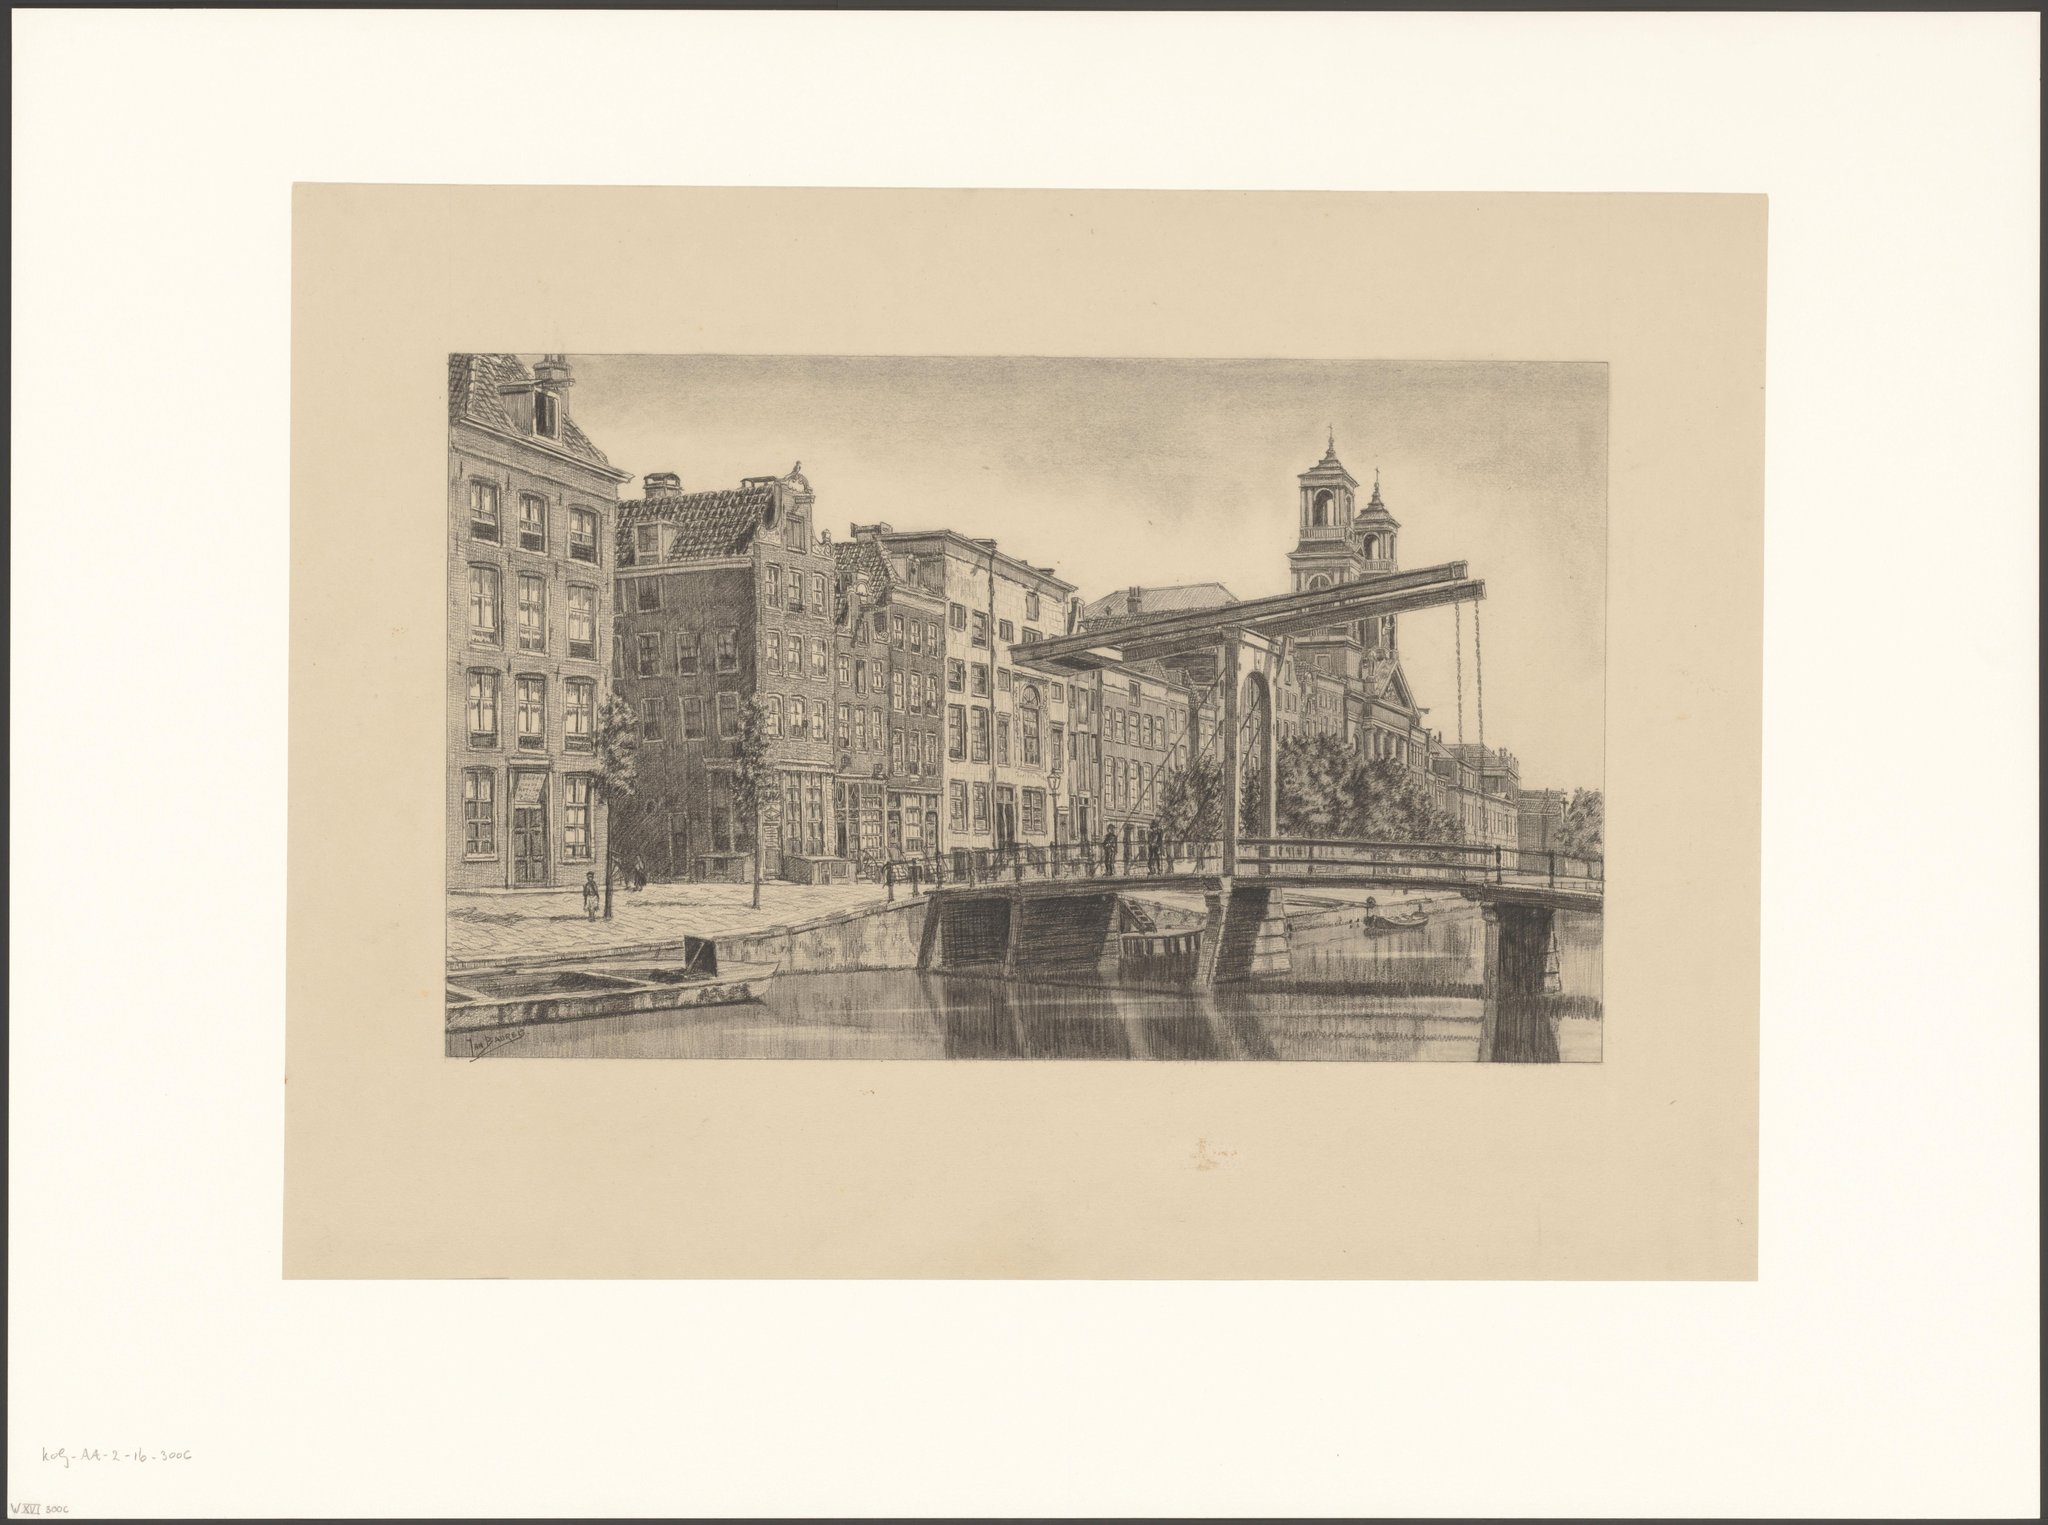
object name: drawing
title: Gezicht op de Houtgracht gezien naar de Mozes en Aäronkerk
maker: jan baureis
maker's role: draughtsman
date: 1850-1882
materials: chalk, paper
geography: amsterdam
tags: city-view in general; 'veduta', canal, church (exterior), bridge in city across river, canal, etc., street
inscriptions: collector's mark: Lugt 800a, signature: ‘Jan Baureis’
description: Tekening binnen de Atlas Van Eck ingedeeld op wijknummer 16.